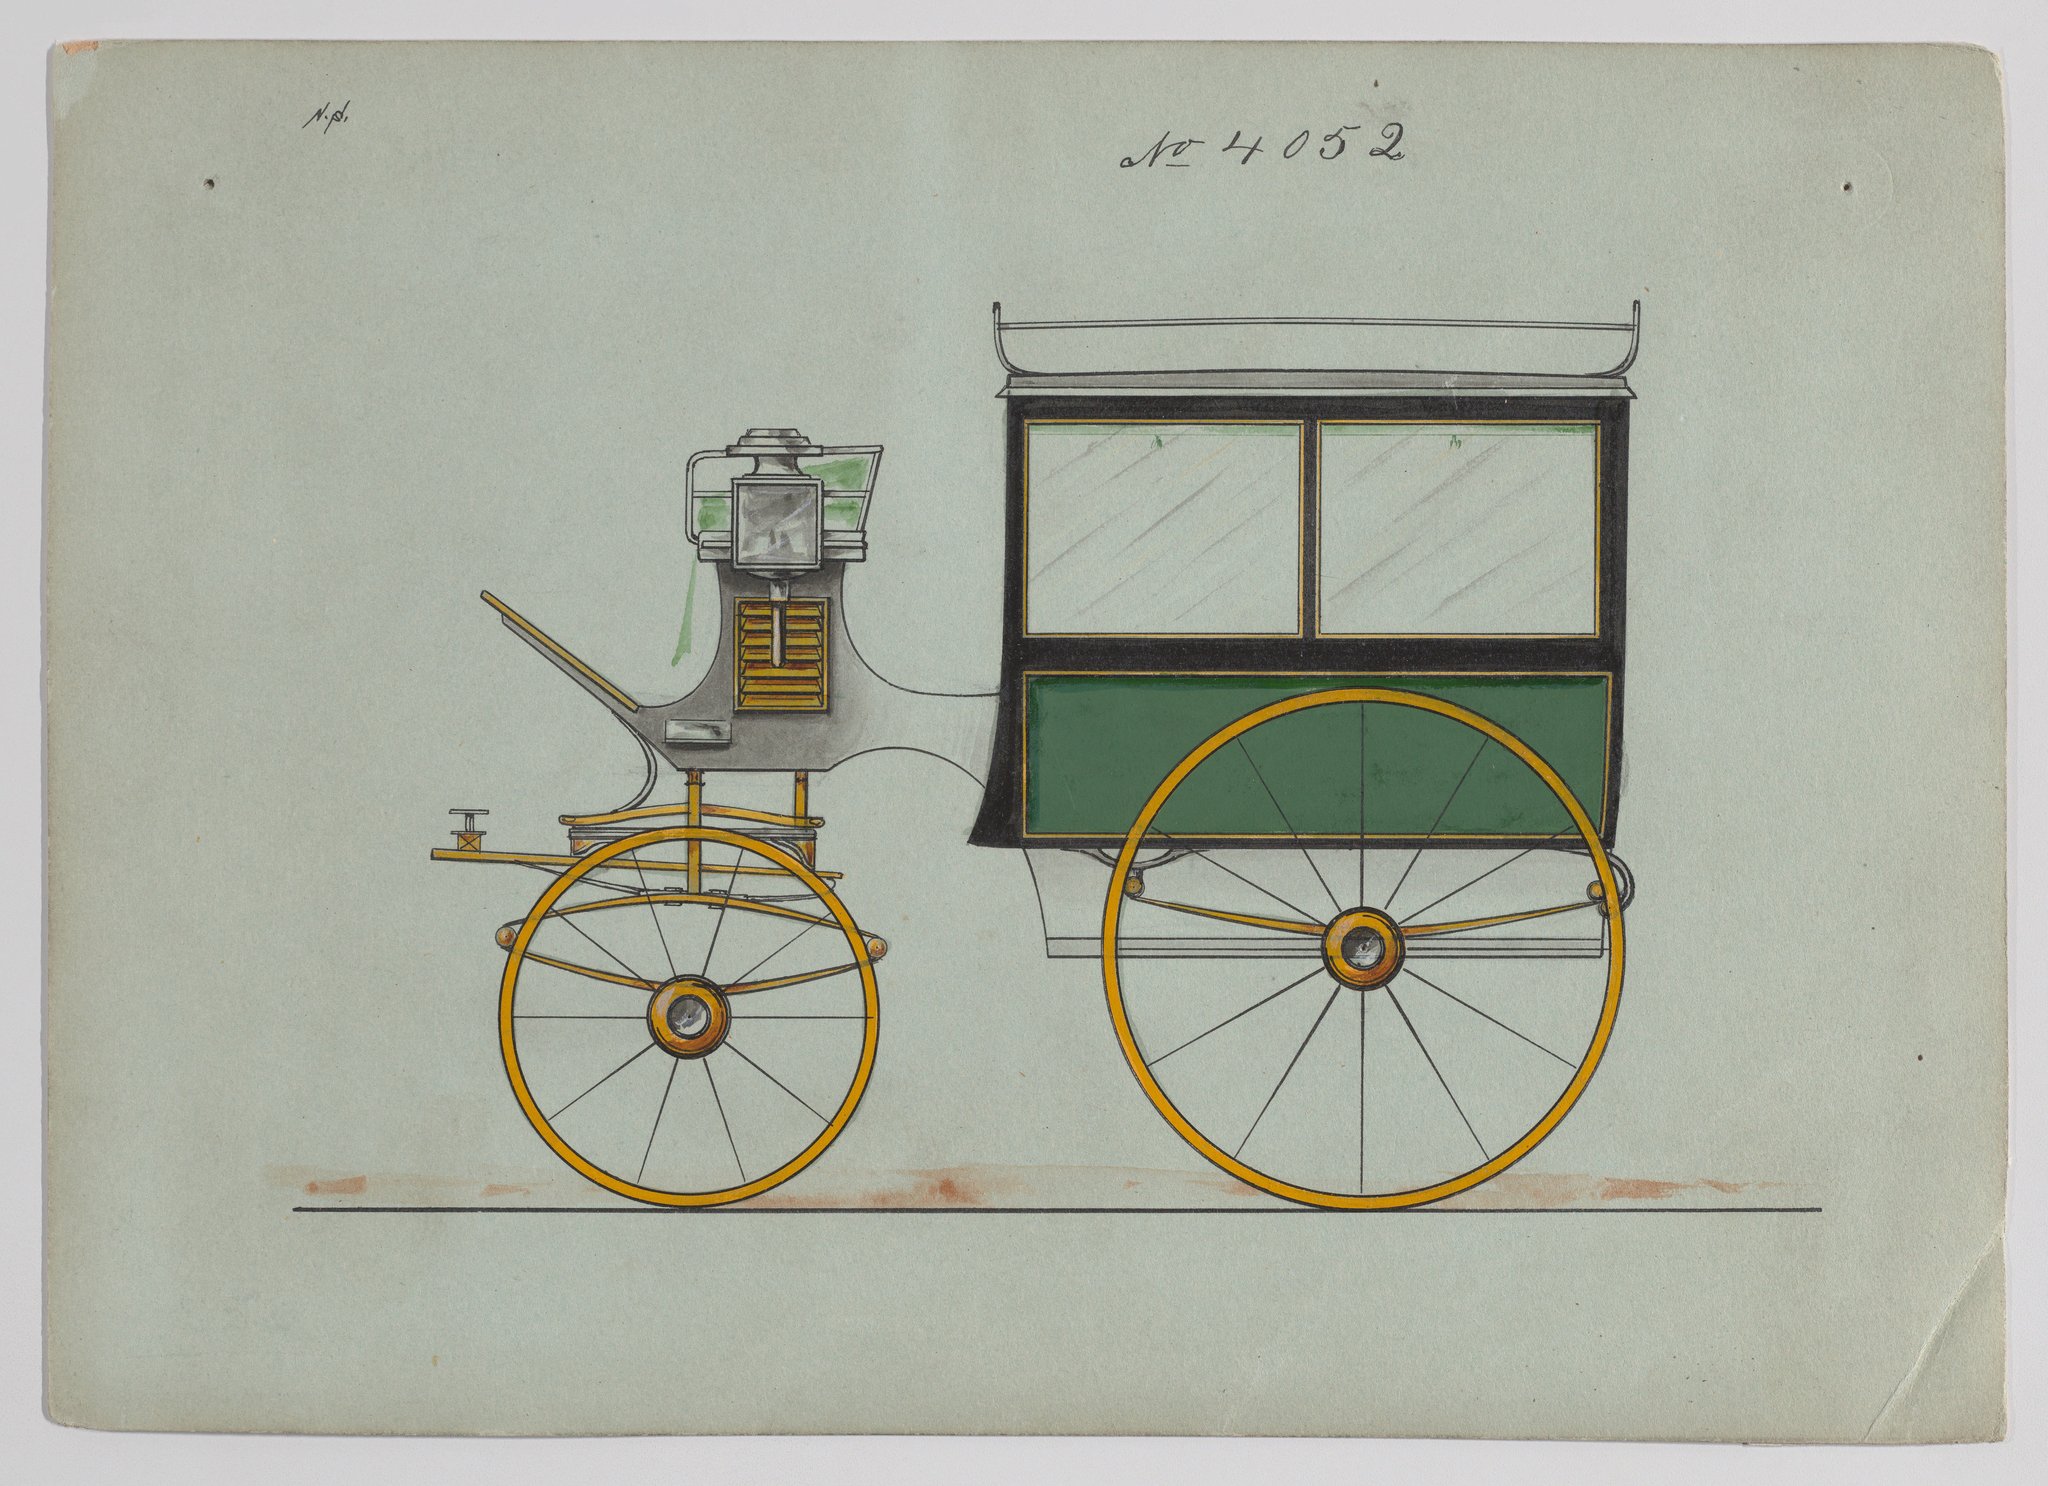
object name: drawing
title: Design for Omnibus or Wagonette, no. 4052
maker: brewster & co.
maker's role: manufacturer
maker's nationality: american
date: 1889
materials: gouache, gum arabic, ink, watercolor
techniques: pen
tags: carriages